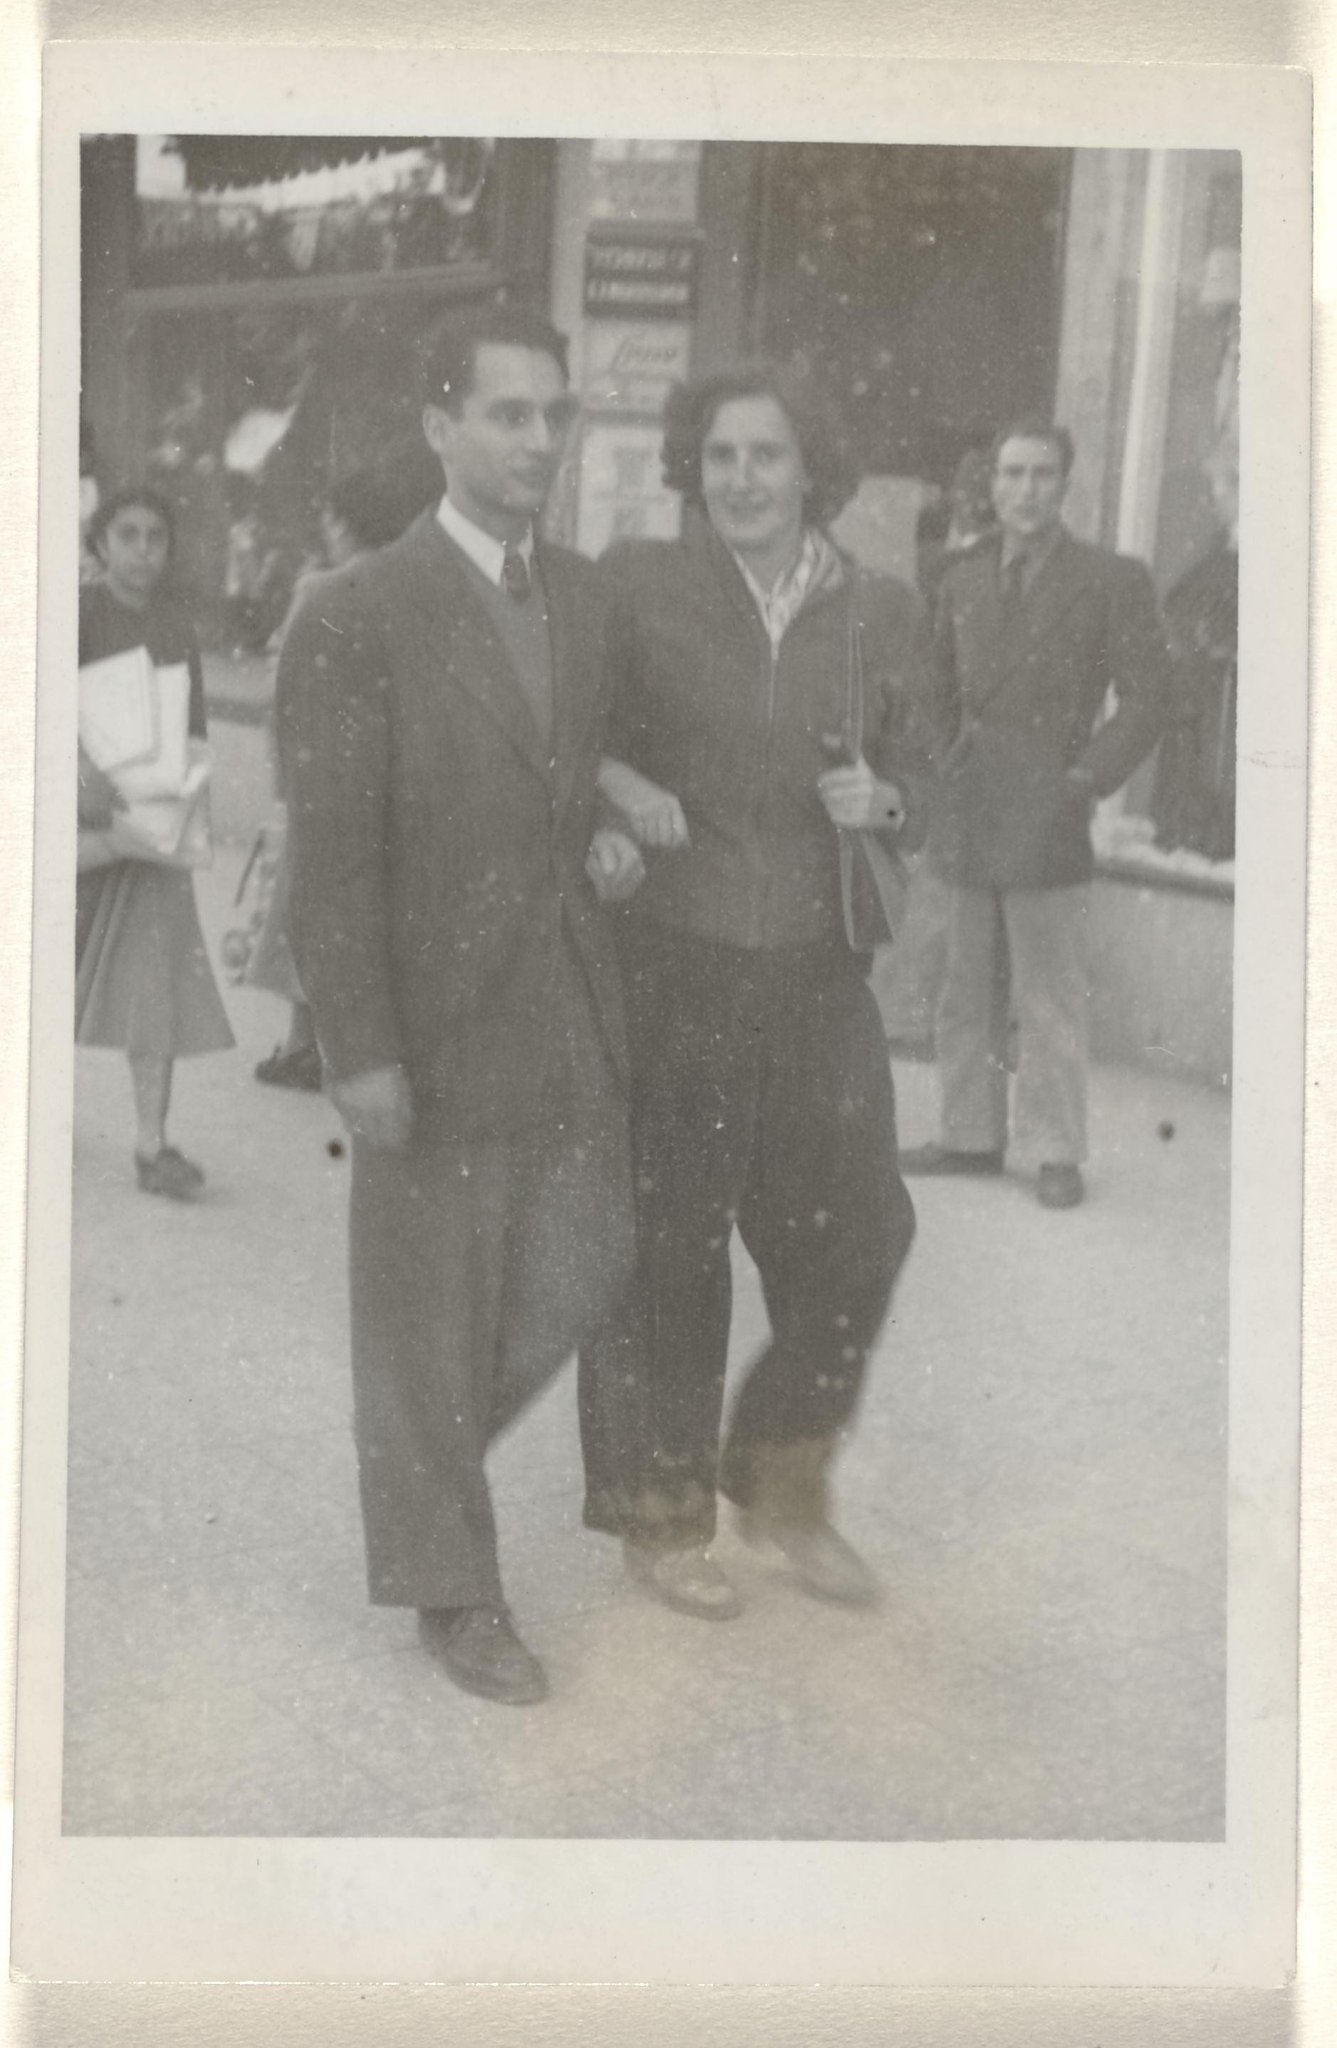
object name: photograph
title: Isabel Wachenheimer lopend op straat, gearmd met haar tweede echtgenoot Karl-Heinz Arndtheim, 1949-1955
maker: Anonymous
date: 1949-1955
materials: photographic support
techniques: gelatin silver print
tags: leiden, isabel wachenheimer-elon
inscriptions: number: ‘43/22’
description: Isabel Wachenheimer lopend op straat, gearmd met haar tweede echtgenoot Karl-Heinz Arndtheim.